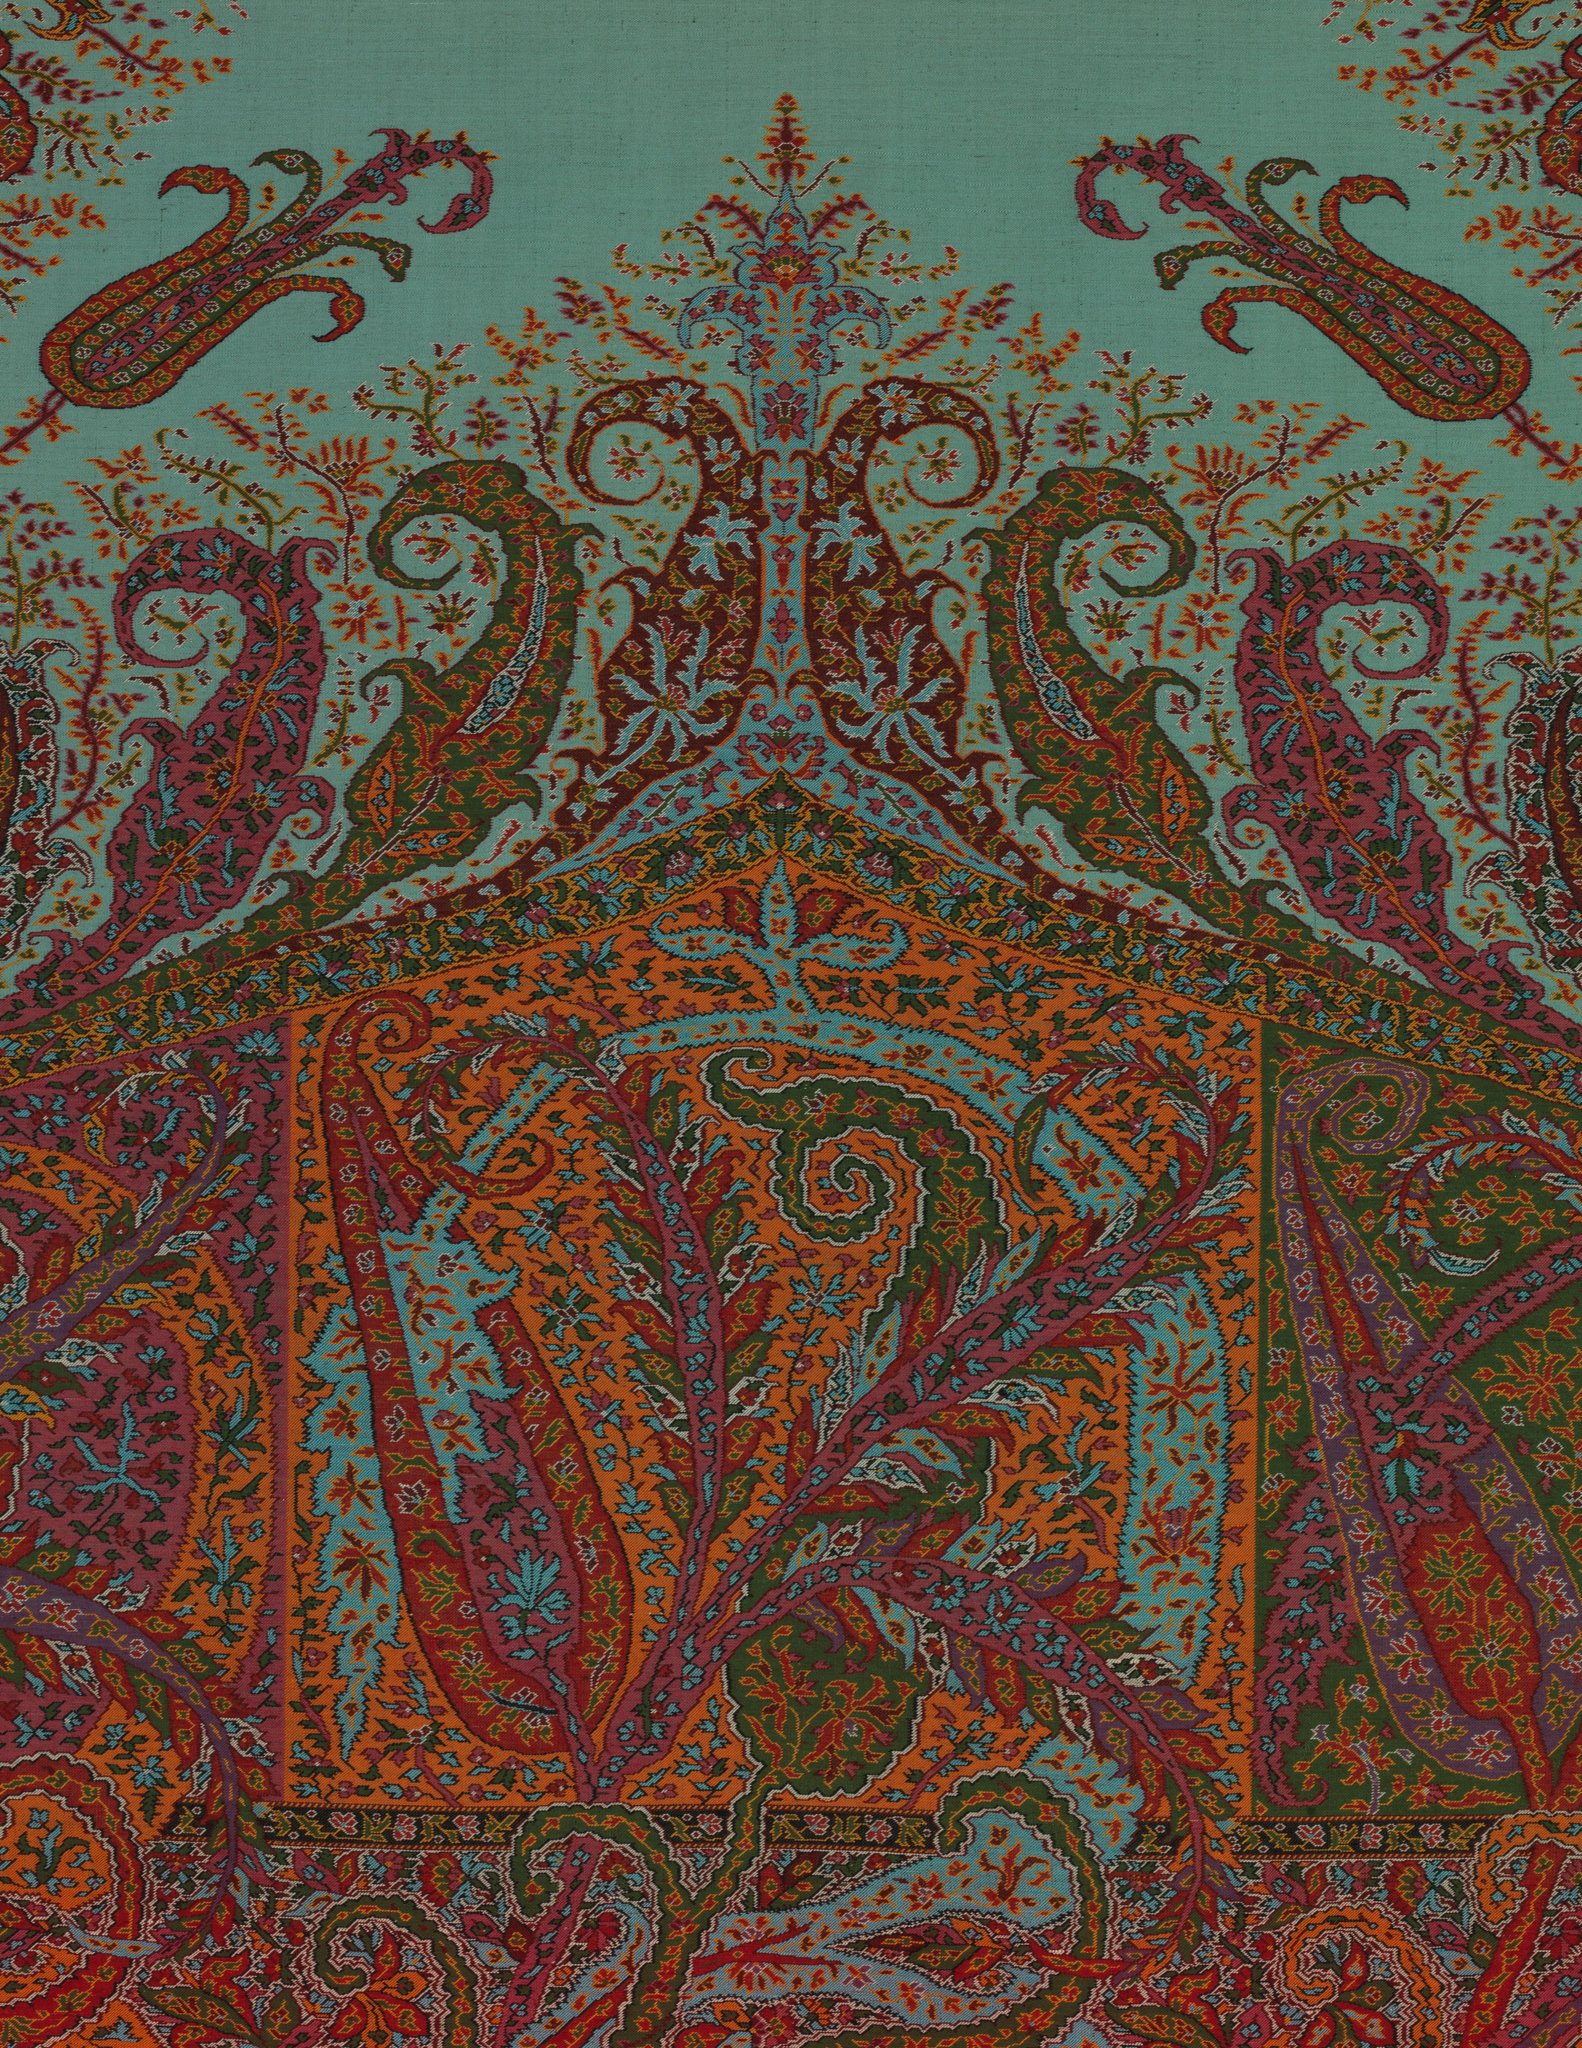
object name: shawl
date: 1834-1866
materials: silk, wool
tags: flowers